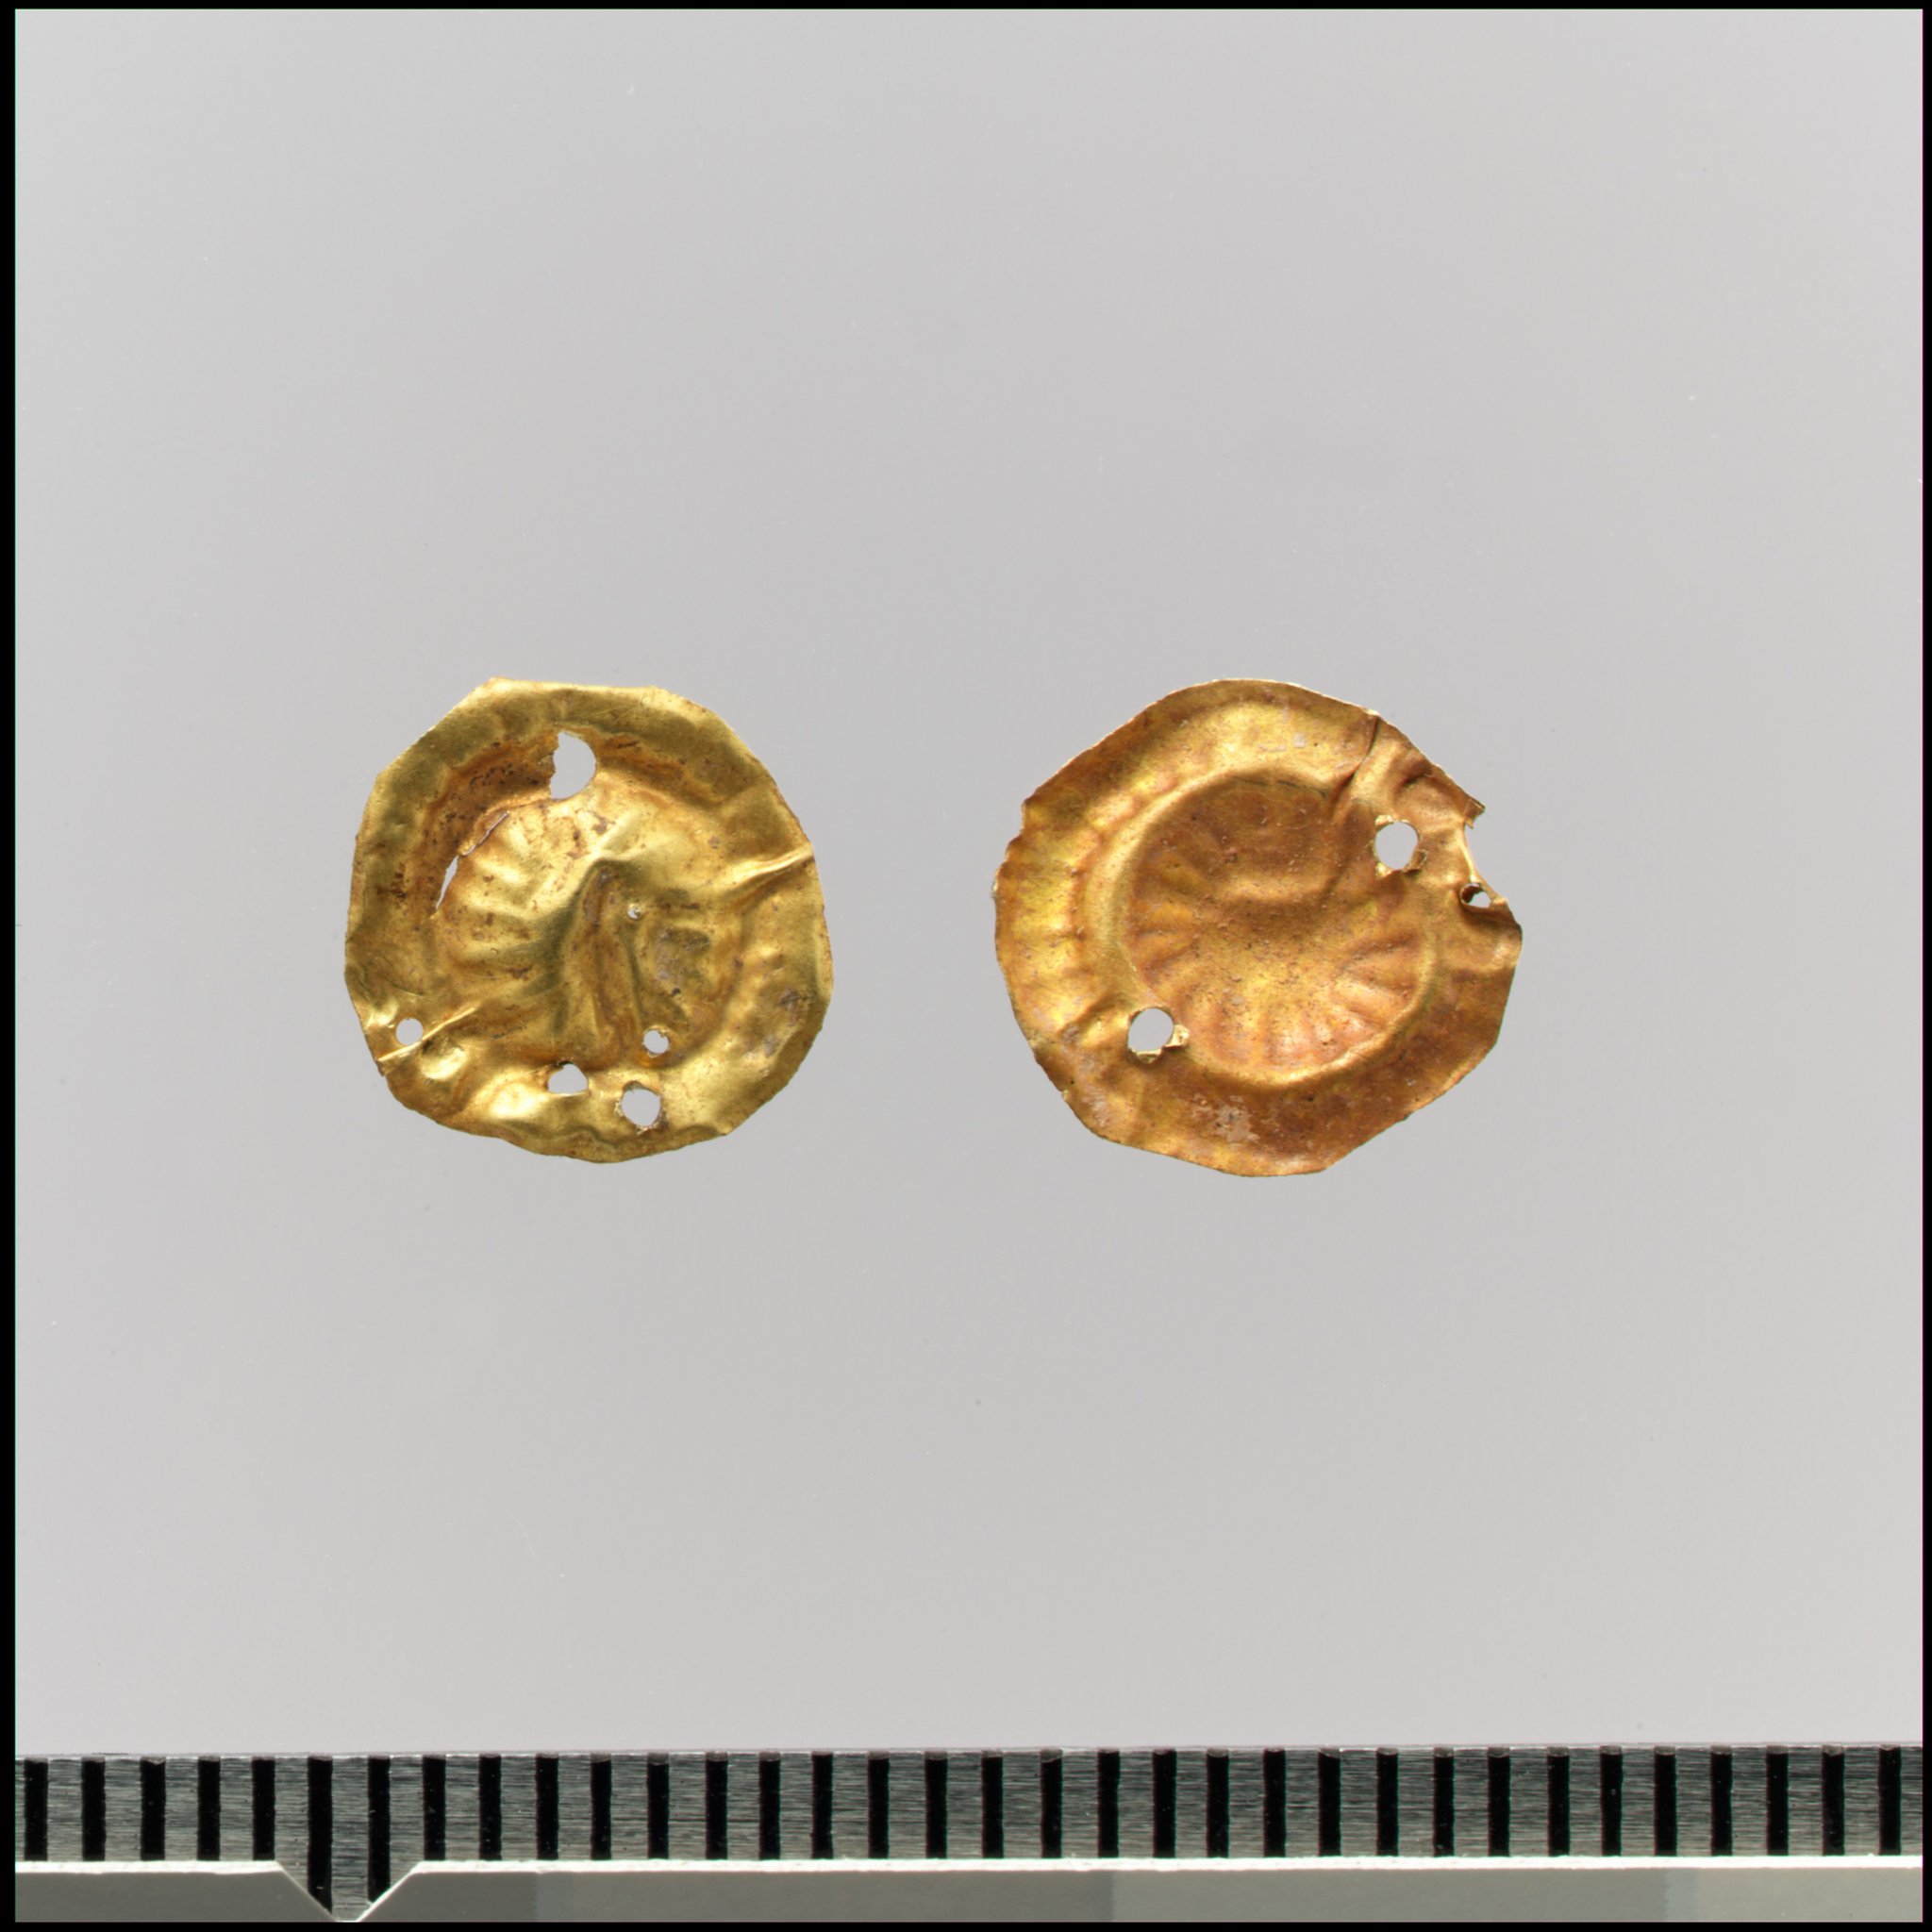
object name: bead ornament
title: Bead ornaments, circular, 37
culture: east germanic or nomadic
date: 401-450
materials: gold